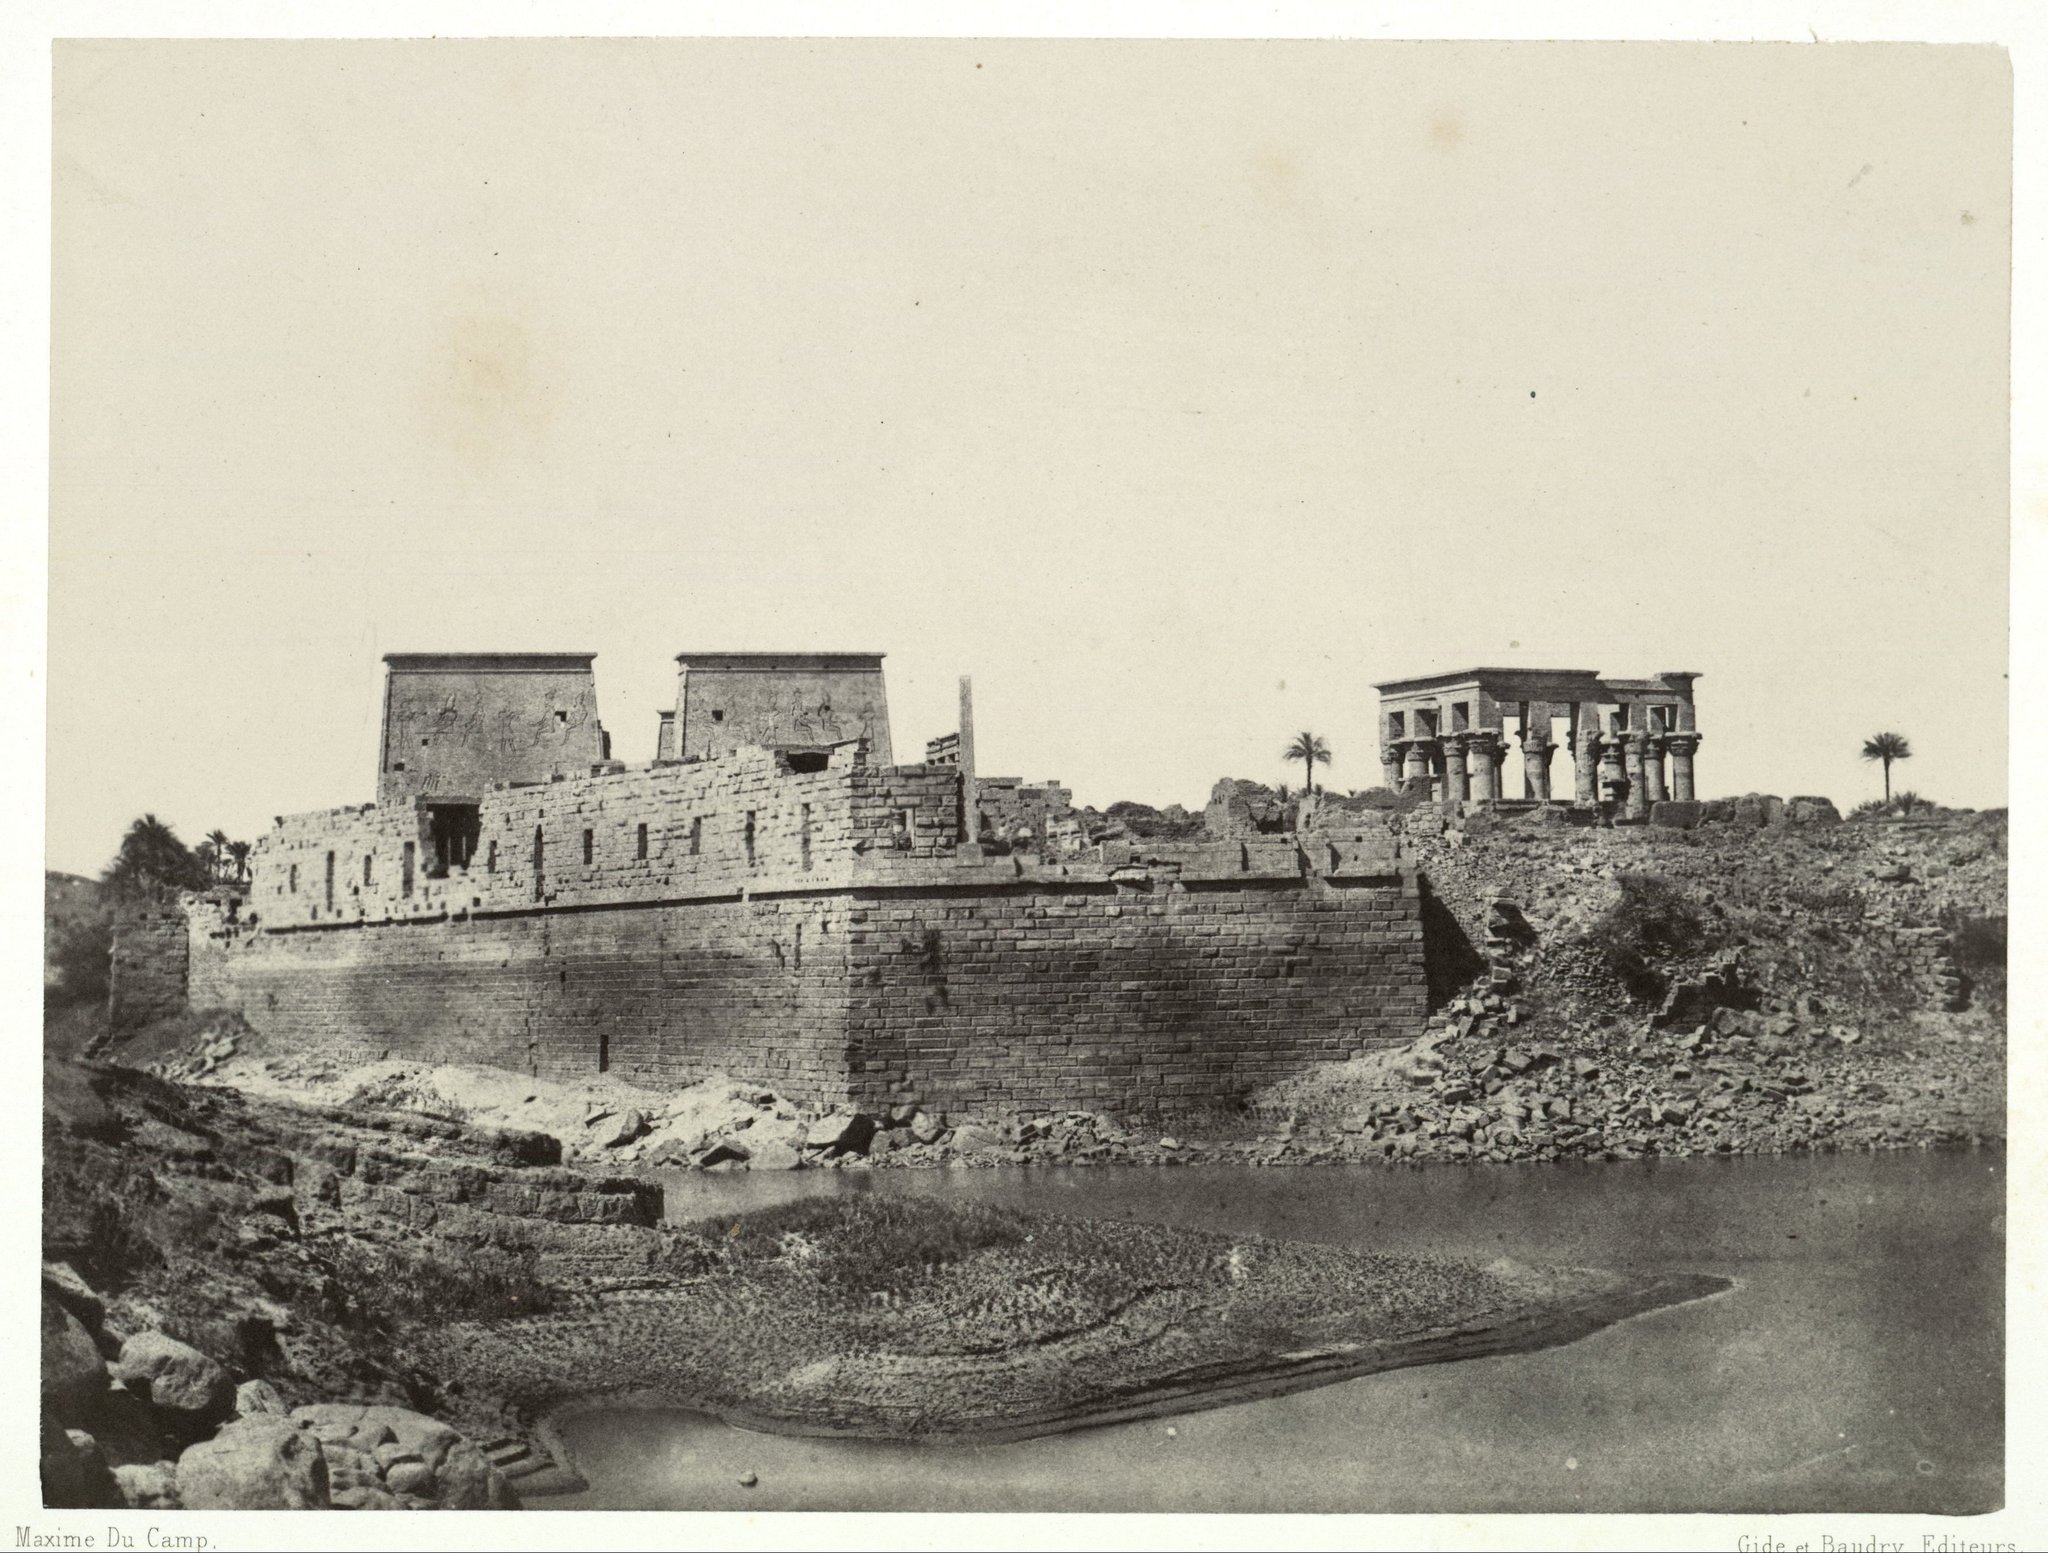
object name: photograph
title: Egypte, Nubie, Palestine et Syrie. Dessins photographiques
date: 1849-1851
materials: cardboard, paper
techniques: salted paper print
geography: paris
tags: temple, shrine ~ egyptian religion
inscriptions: check stamp: ‘MACGILL/ 7/ HANOVER/ ST./ EDINR.’, inscription: ‘NUBIE./ Maxime Du Camp./ Gide et Baudry, Editeurs./ PHILOE./ VUE GÉNÉRALE A L'ANGLE S-O./ Imprimerie Photographique de Blanquard-Evrard, à Lille./ Pl. 69.’